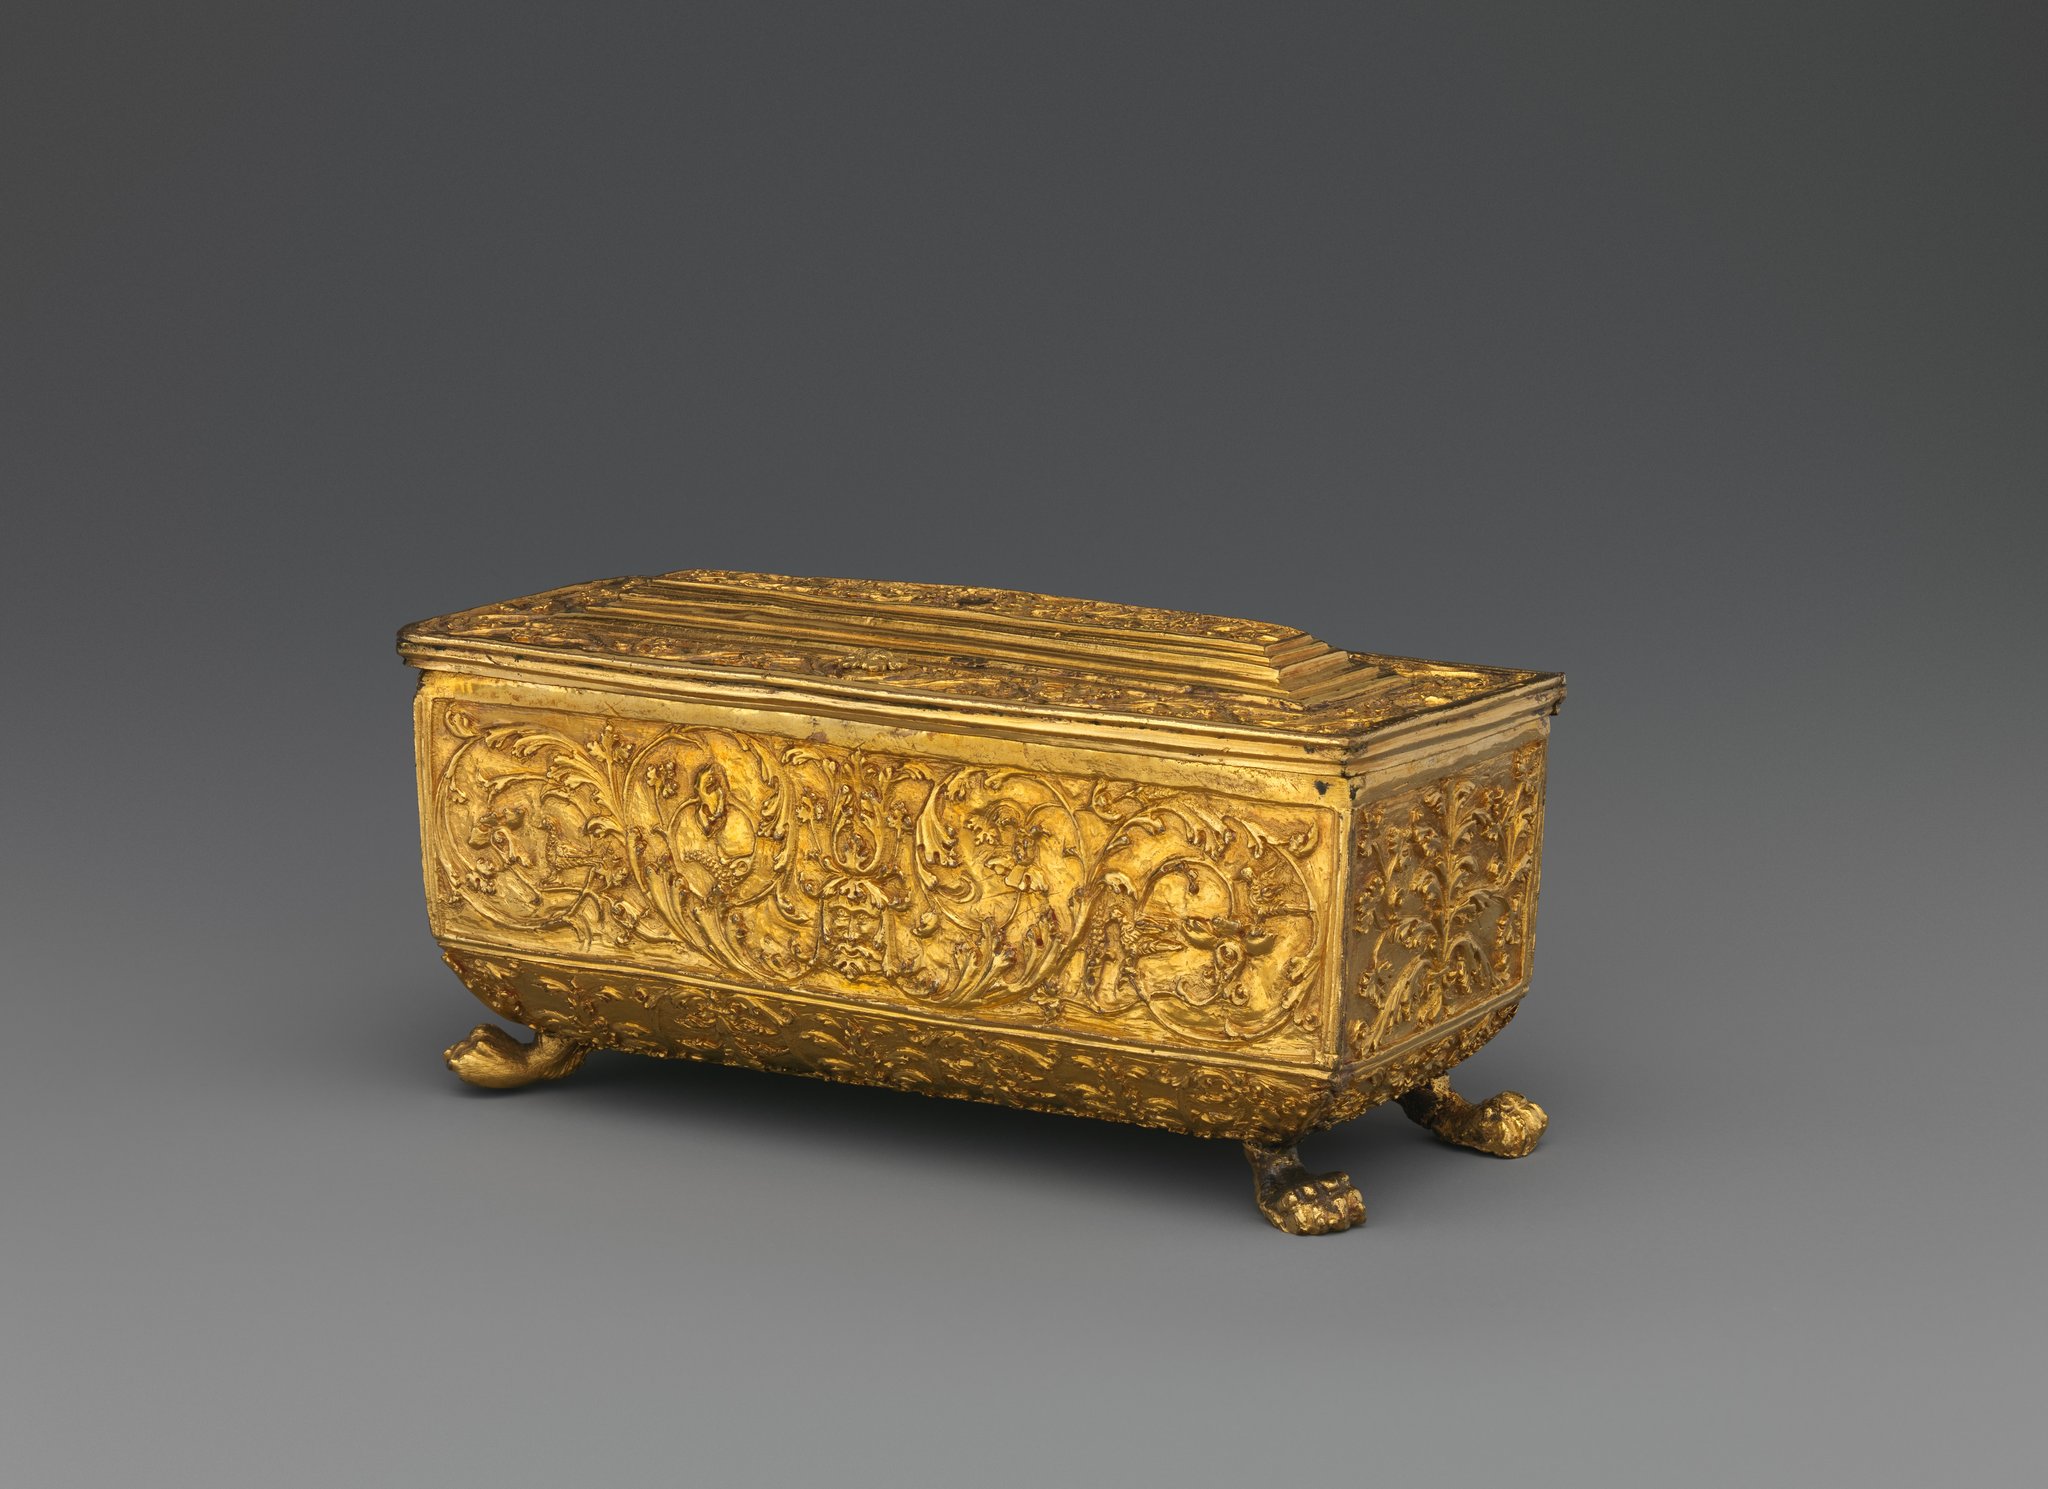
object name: casket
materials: gold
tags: faces,coat of arms